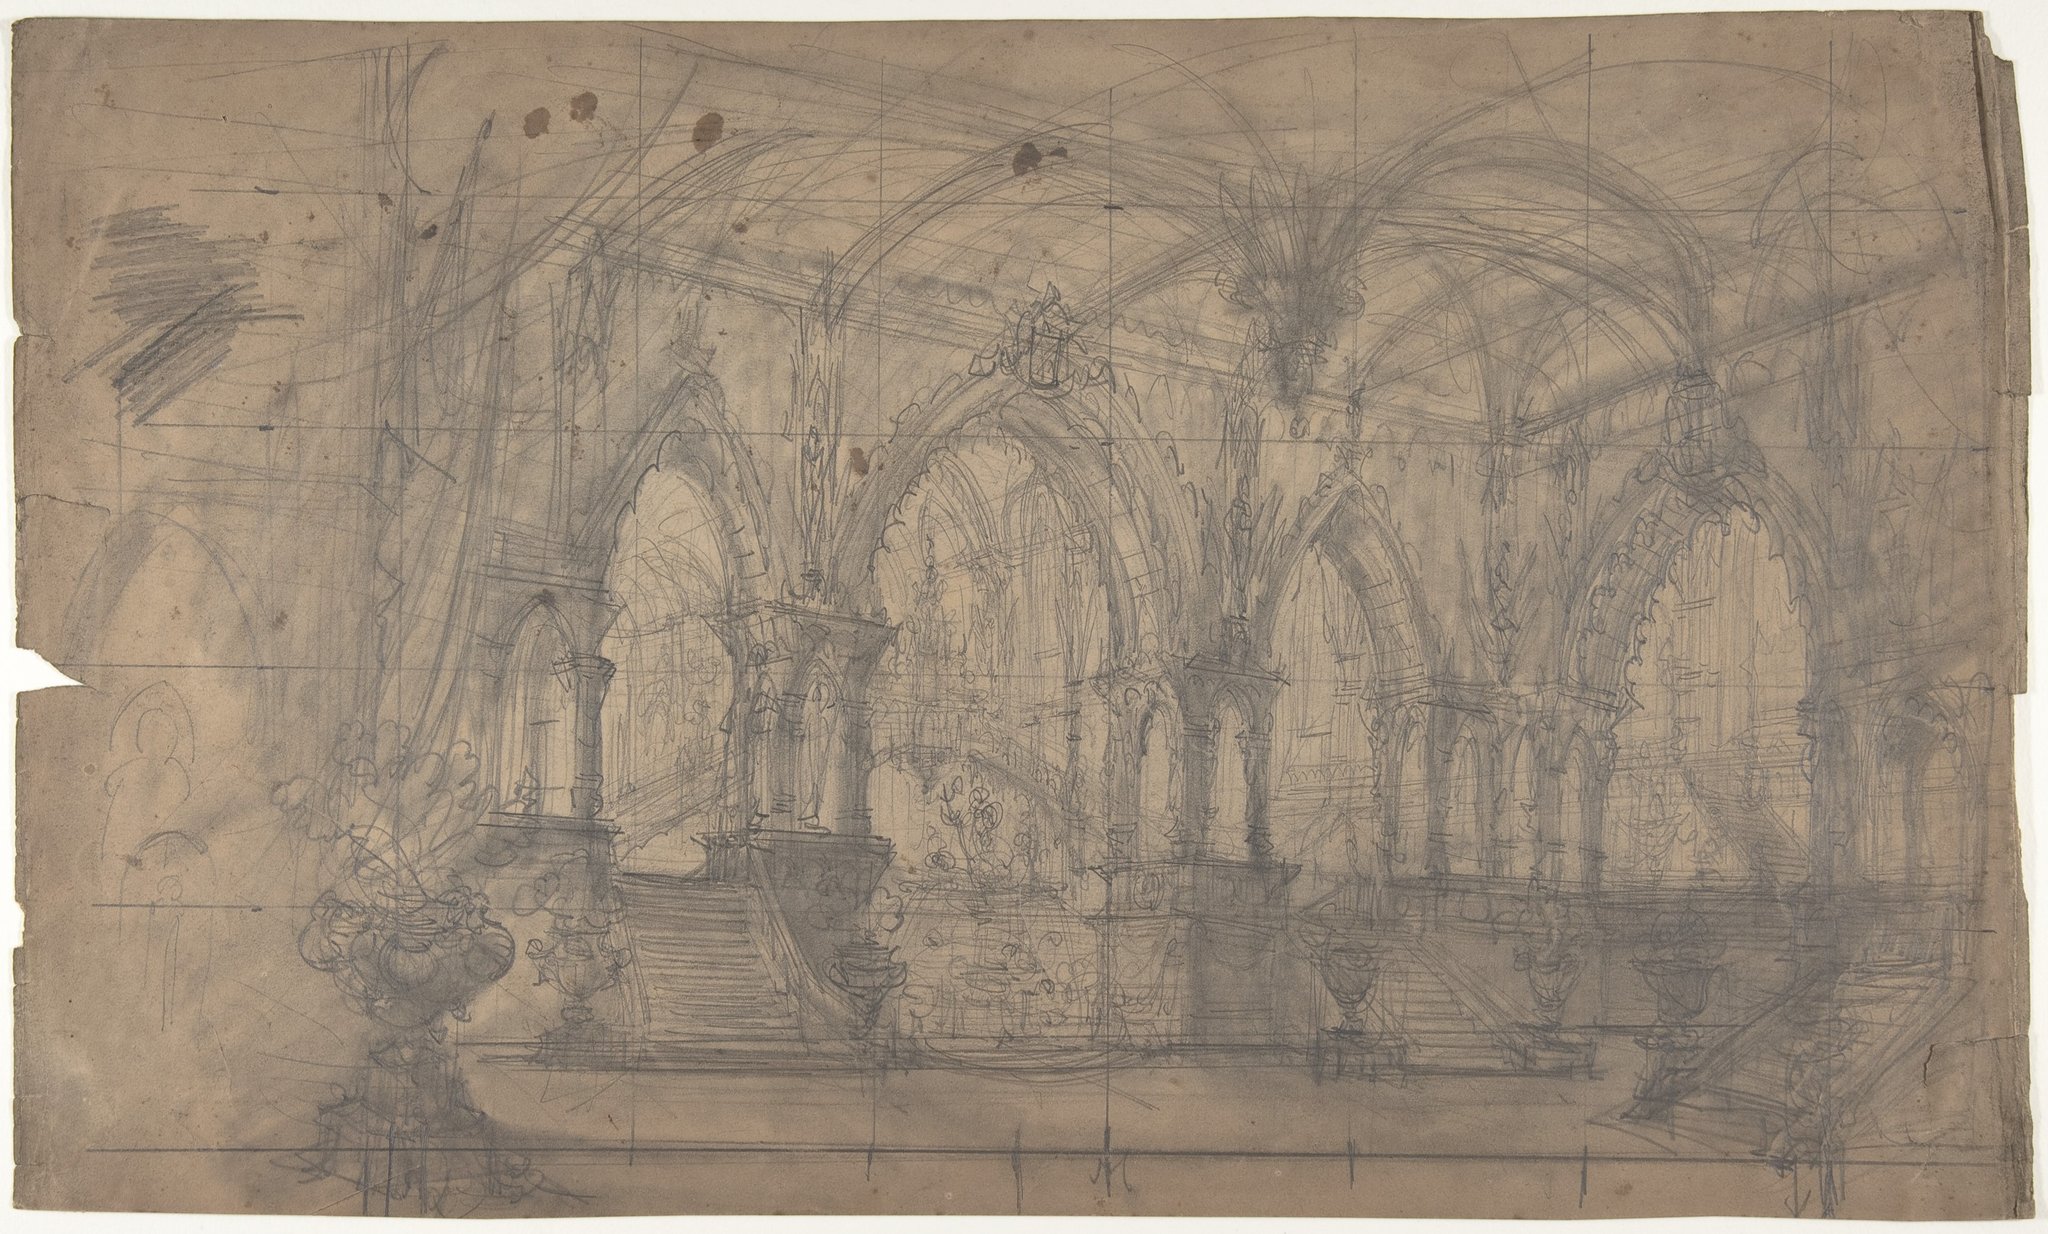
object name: drawing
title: Design for a Stage Set at the Opéra, Paris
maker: eugène cicéri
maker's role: artist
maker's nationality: french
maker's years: 1813-1890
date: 1830-1890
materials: graphite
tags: theatre,arches,stage design